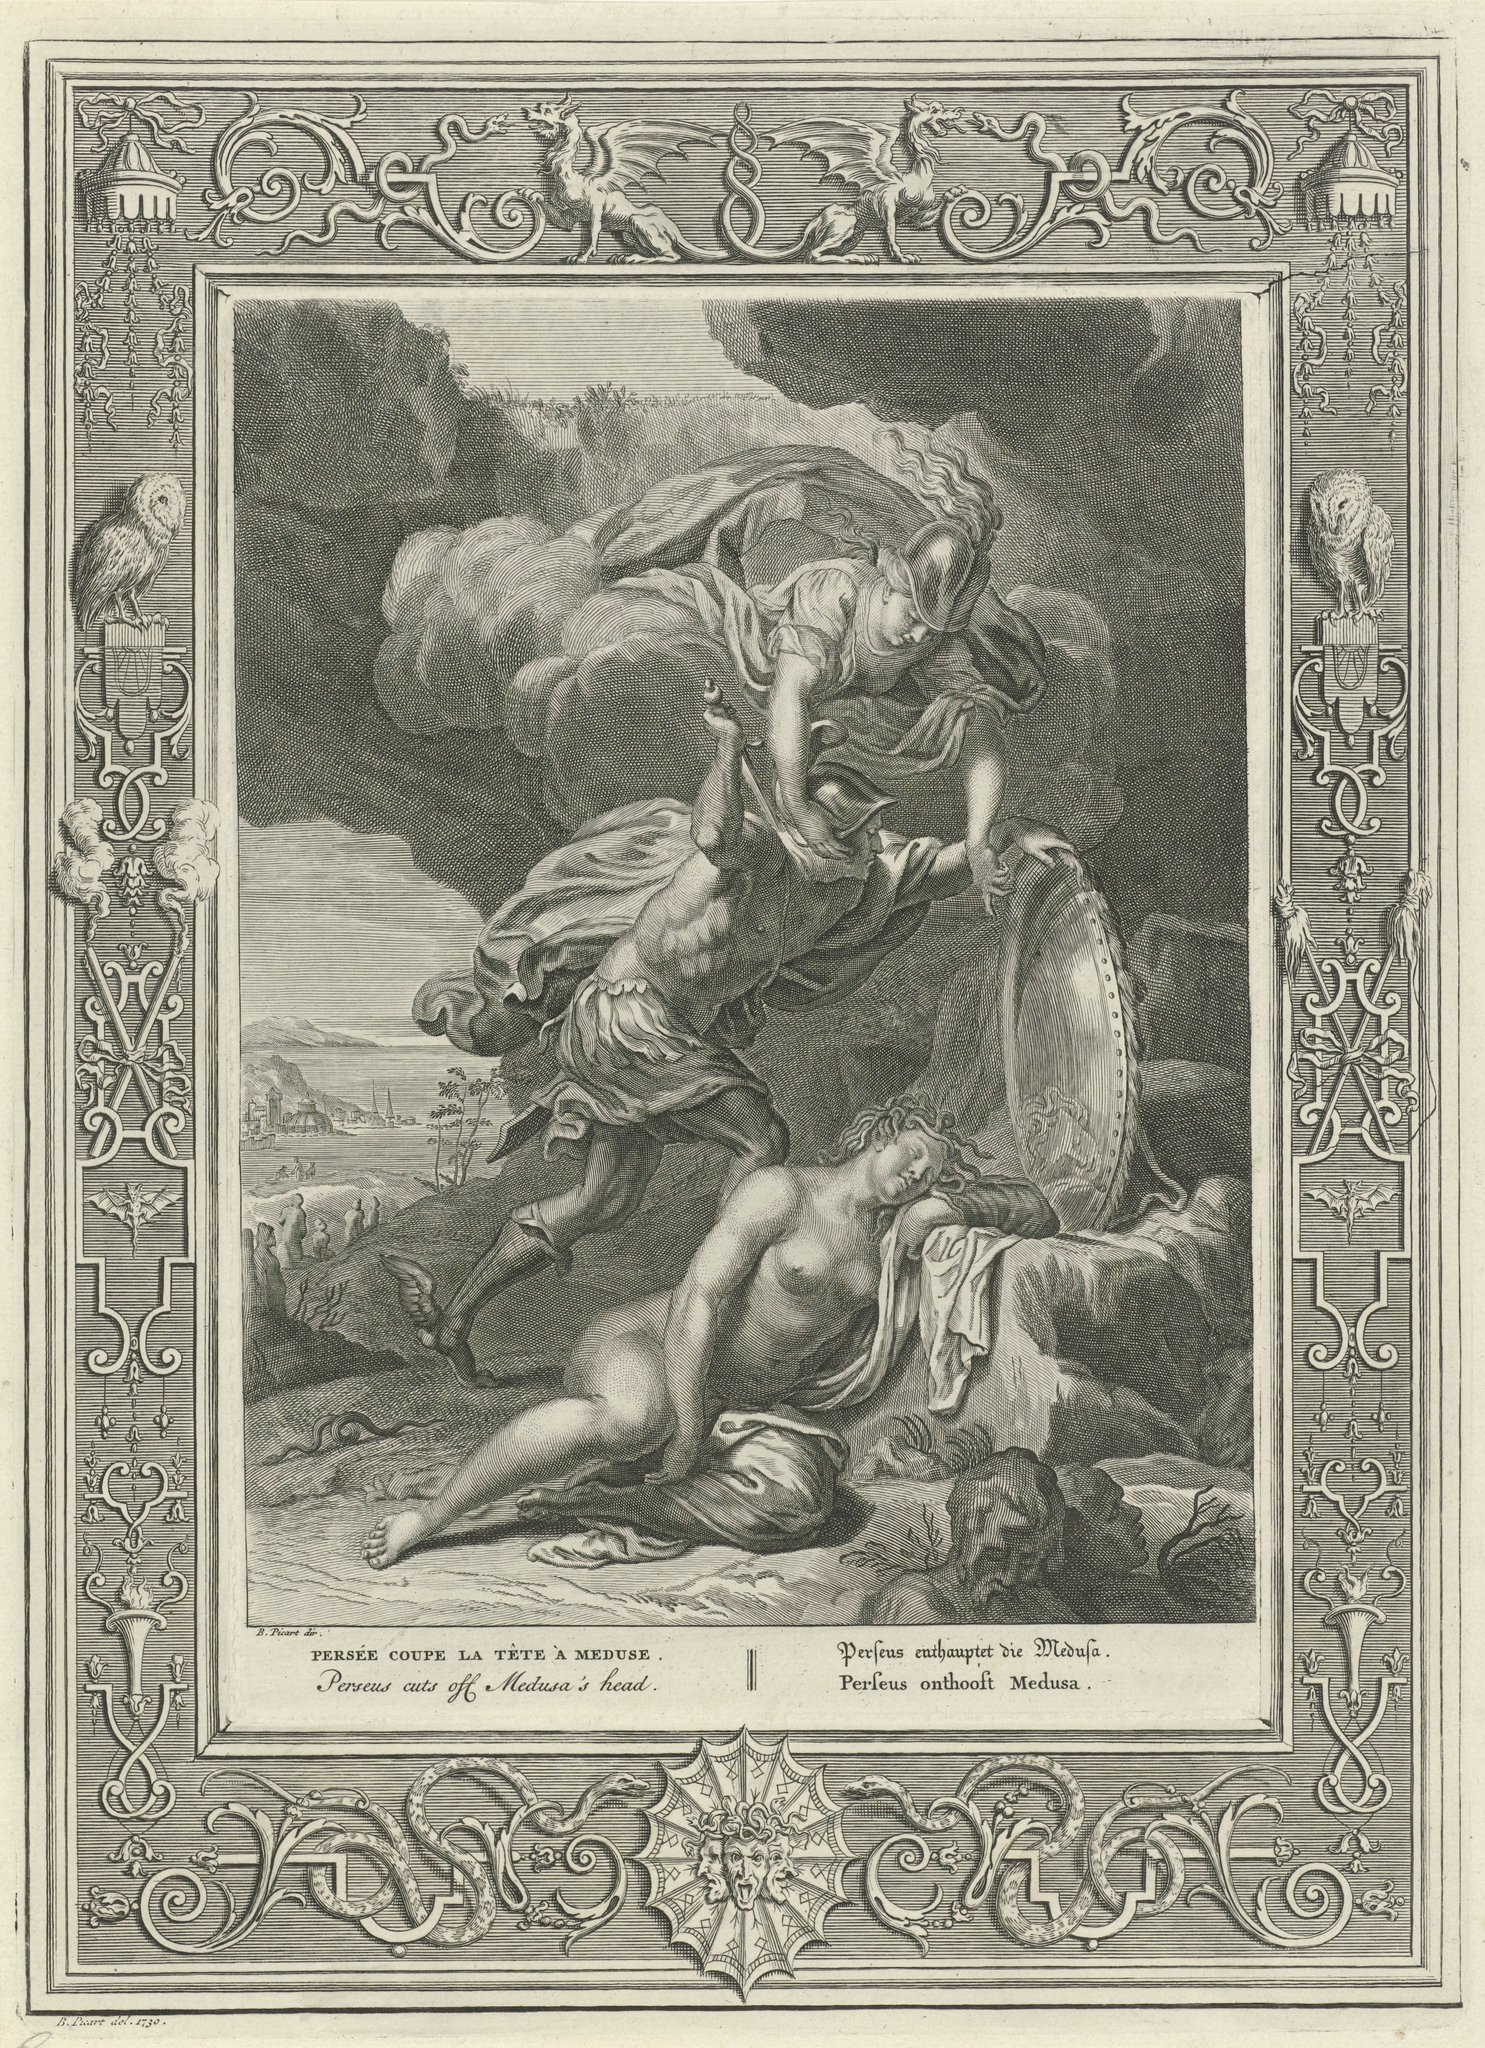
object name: print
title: Perseus doodt Medusa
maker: bernard picart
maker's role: draughtsman, print maker, publisher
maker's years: 1673-1733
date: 1730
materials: paper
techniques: engraving, etching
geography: amsterdam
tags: perseus beheading medusa, scrollwork, strapwork ~ ornament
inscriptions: collector's mark: Lugt 2228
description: Perseus staat op het punt Medusa te onthoofden met zijn zwaard. Hij kijkt naar haar spiegelbeeld in zijn gepolijste schild, dat door Minerva wordt vastgehouden. In de marge de titel in het Frans, Engels, Duits en Nederlands. De voorstelling is gedecoreerd met een ornamentele rand.